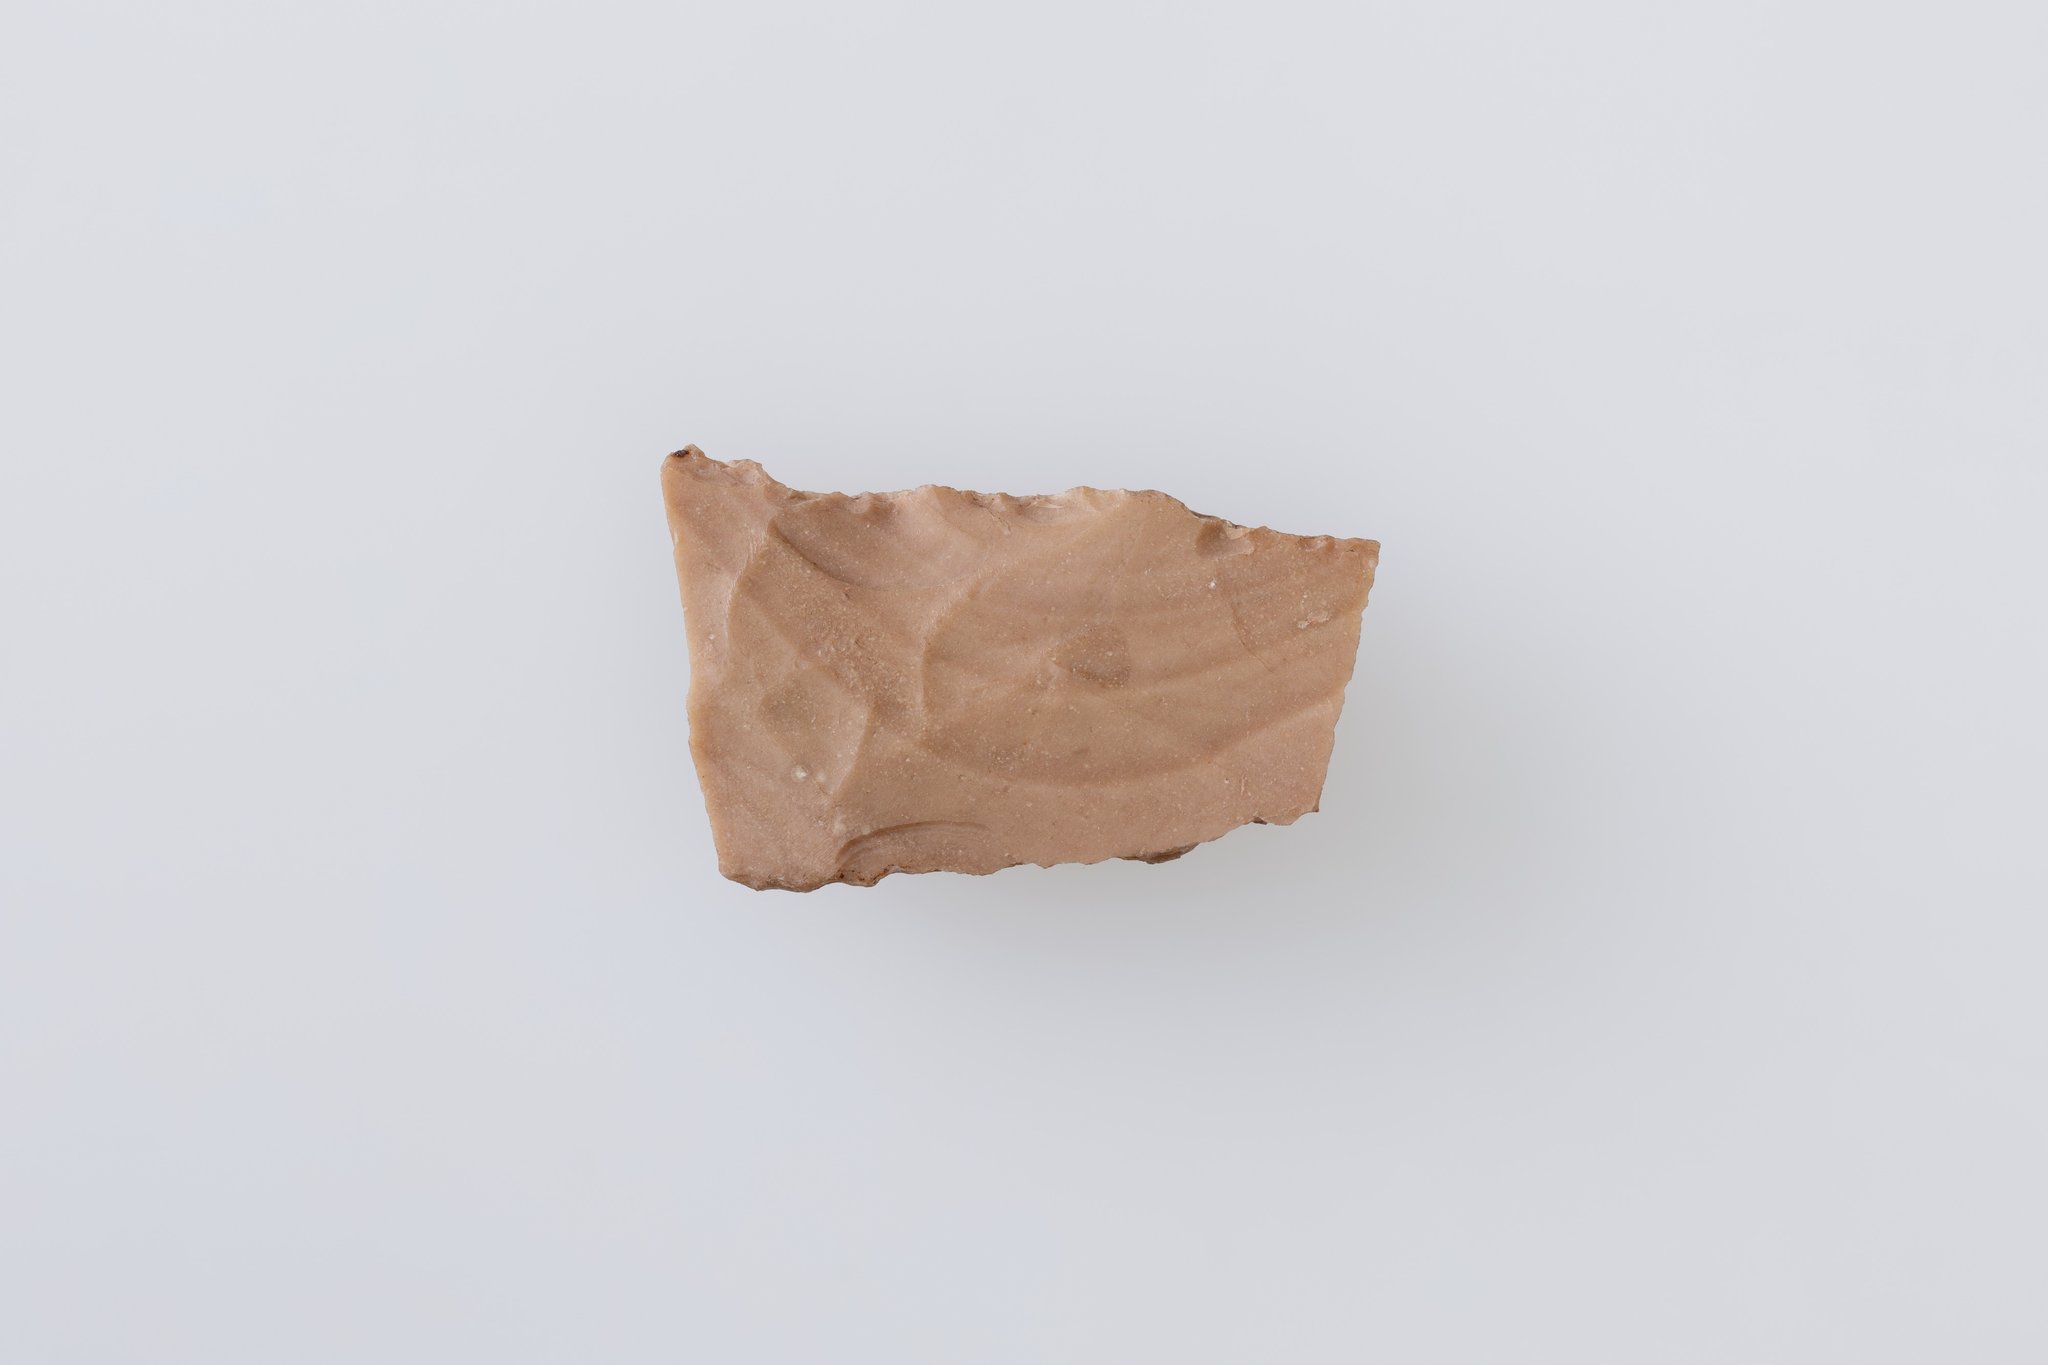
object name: tool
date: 3100-2649 BCE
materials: stone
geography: egypt